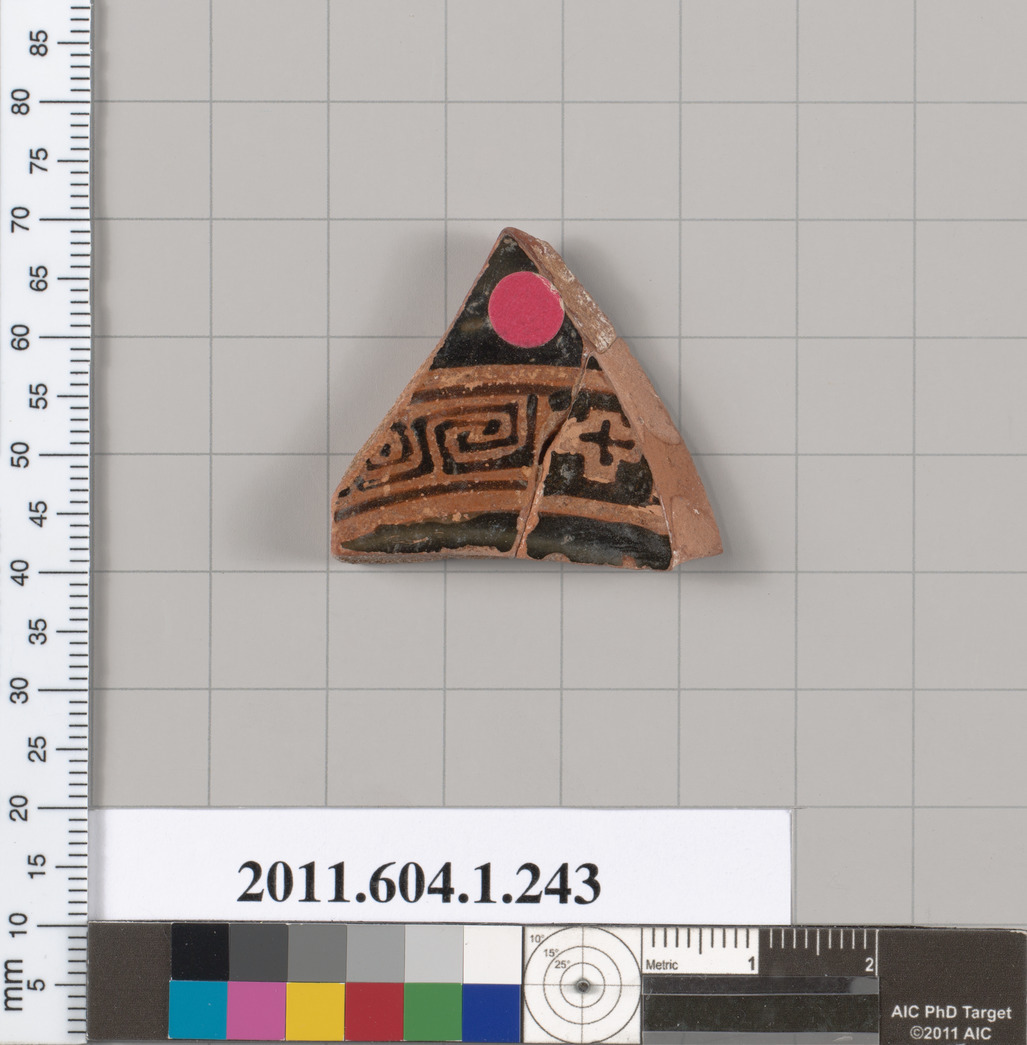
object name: kylix fragment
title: Terracotta fragment of a kylix (drinking cup)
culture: greek, attic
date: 475-451 BCE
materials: terracotta